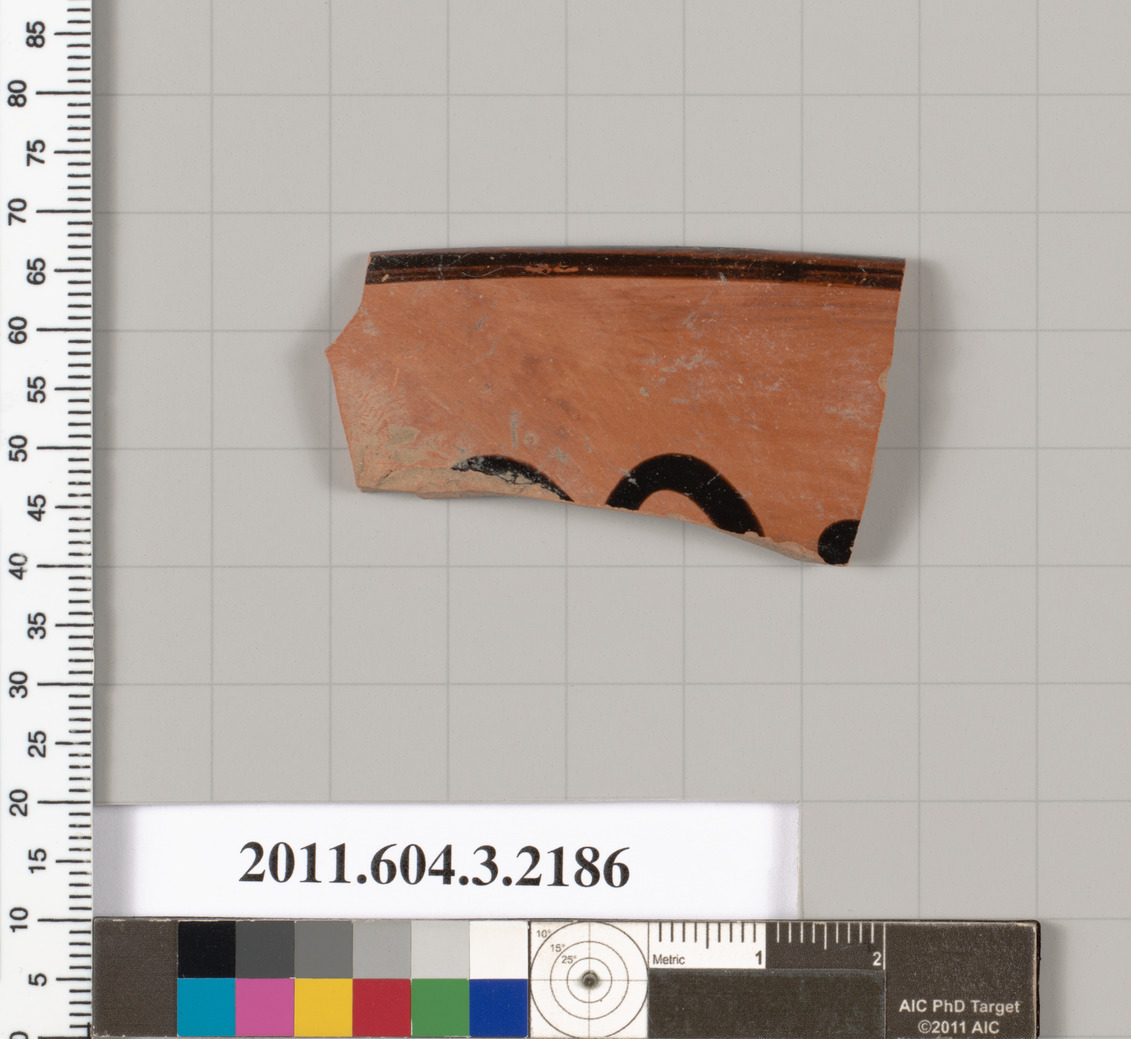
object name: kylix fragment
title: Terracotta rim fragment of a kylix (drinking cup)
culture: greek, attic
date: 500-468 BCE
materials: terracotta